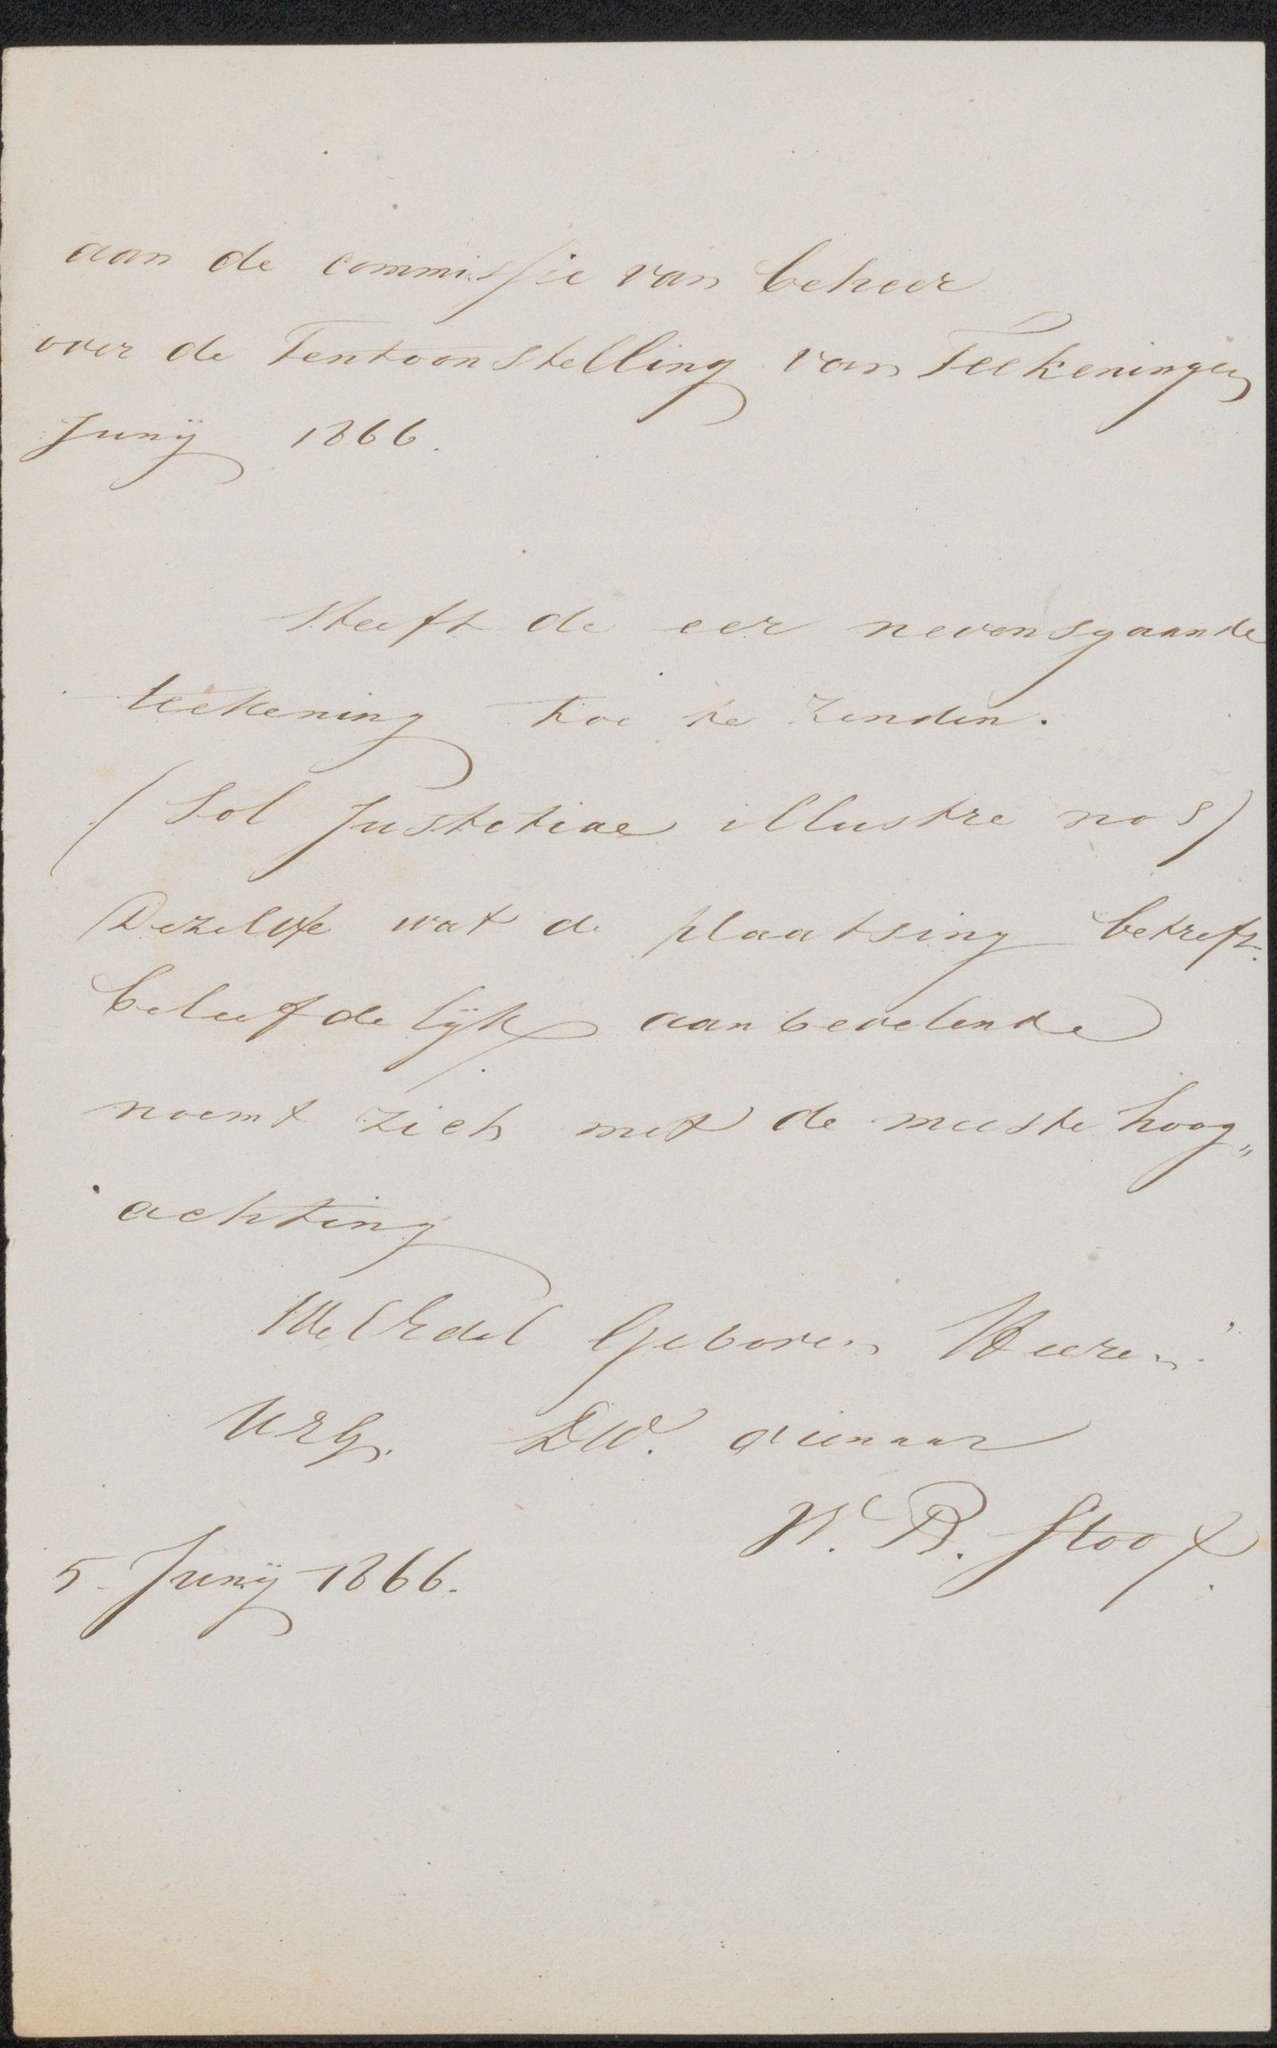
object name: letter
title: Brief aan de Commissie van de Tentoonstelling van Levende Meesters in Utrecht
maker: willem benedictus stoof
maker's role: print maker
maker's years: 1816-1900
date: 1866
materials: ink, paper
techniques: pen, writing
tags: drawing, exhibition ~ art